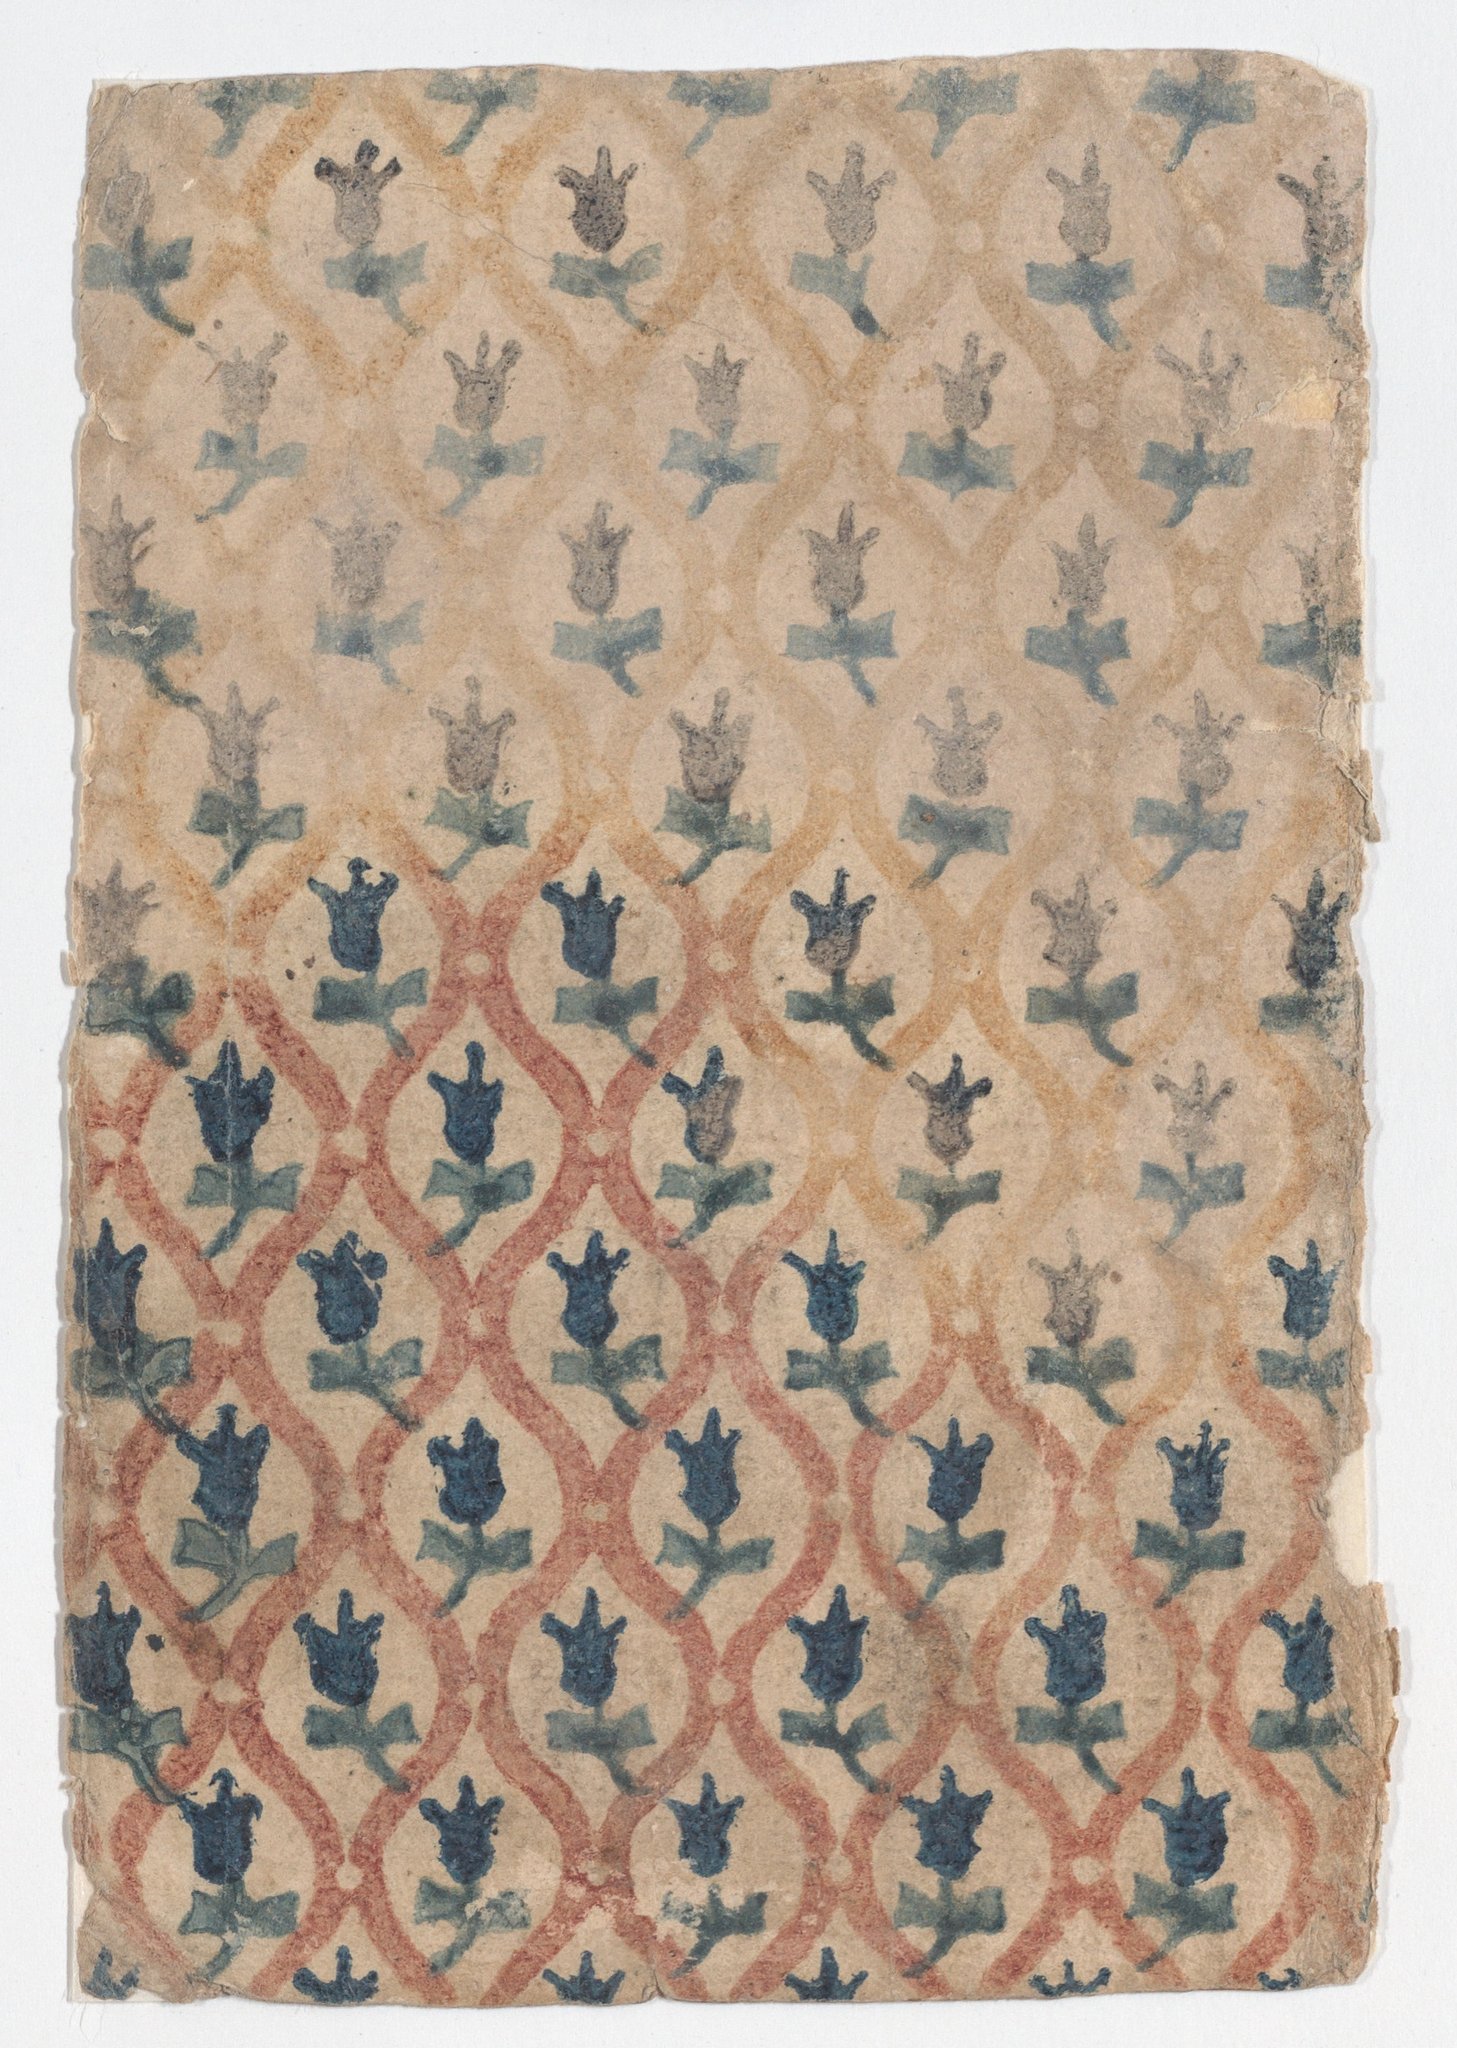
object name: print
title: Sheet with overall pattern of tulips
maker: Anonymous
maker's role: artist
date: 1801-1900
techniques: relief print